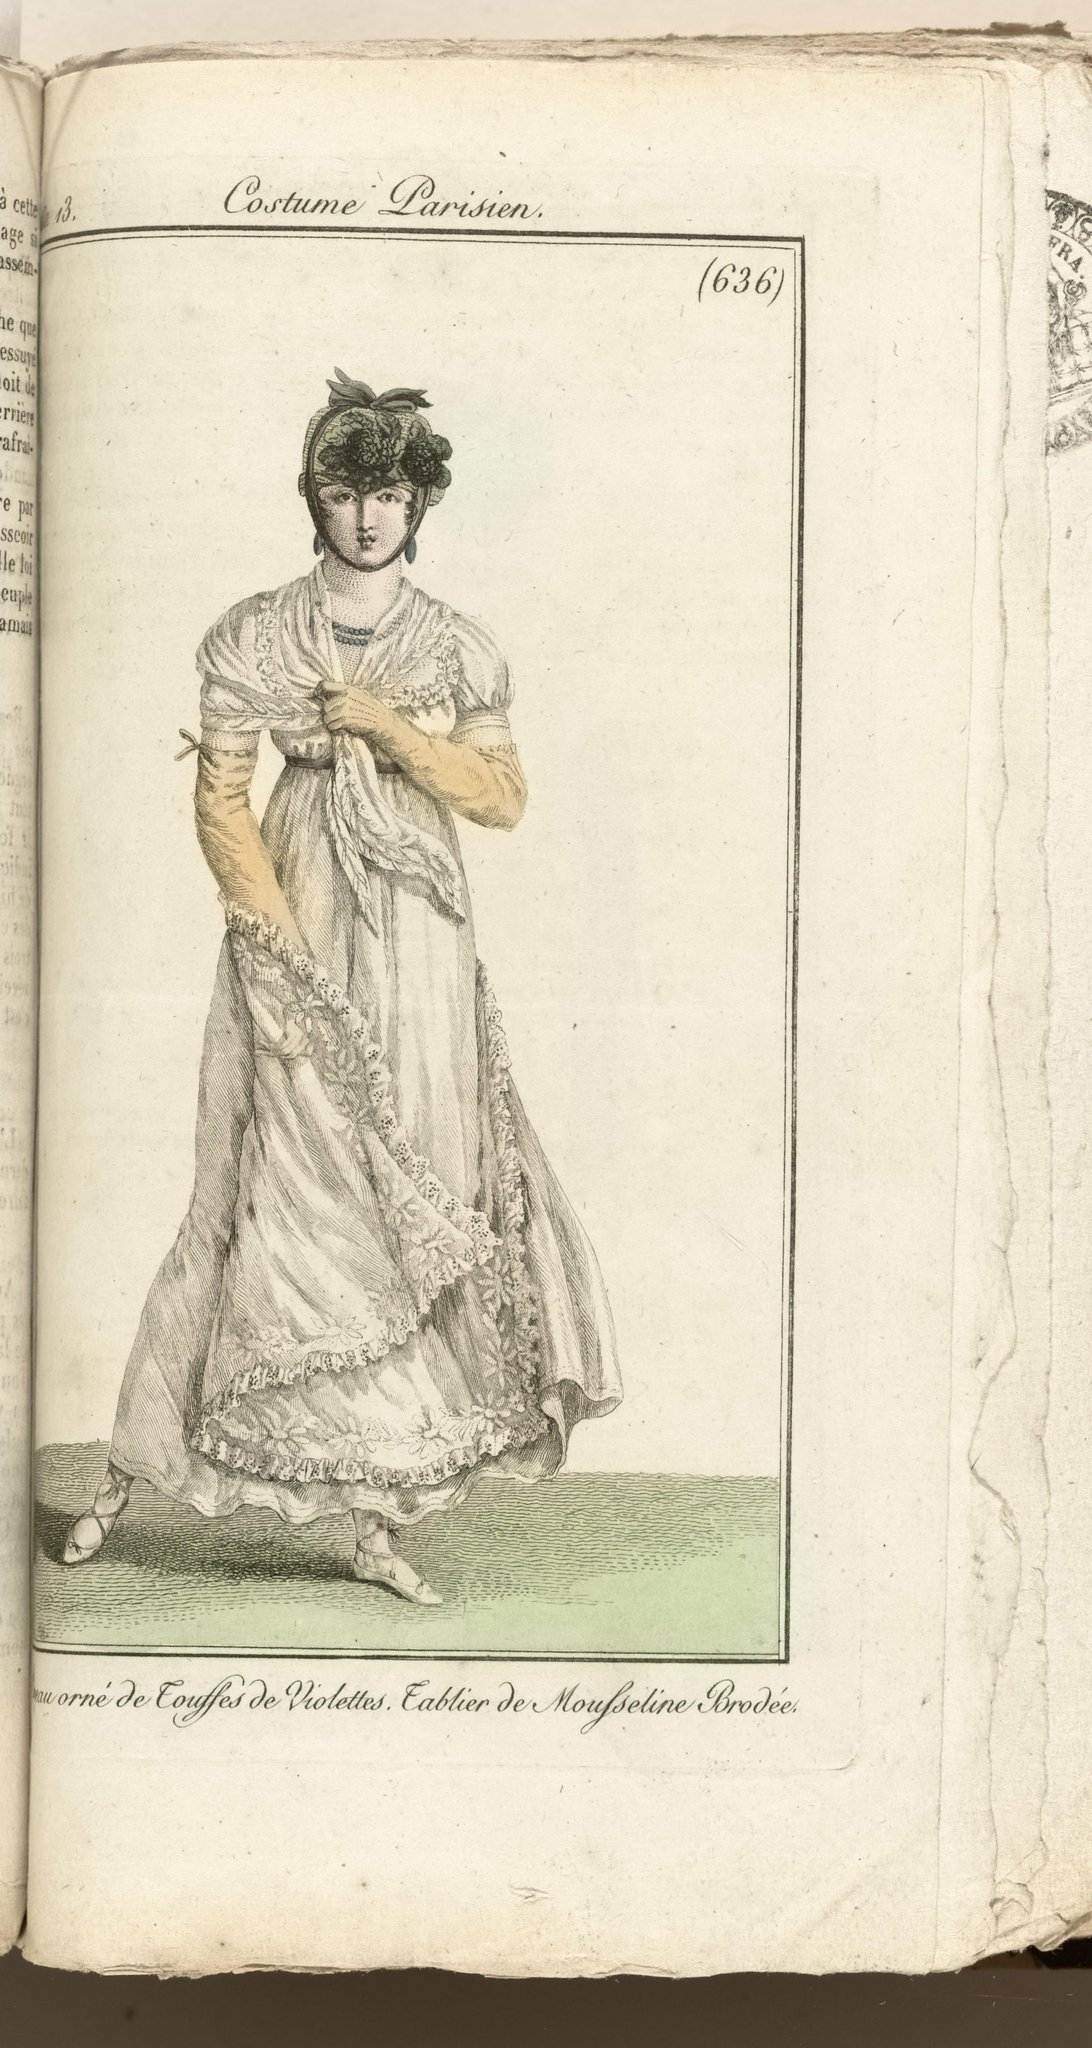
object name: fashion print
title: Journal des Dames et des Modes, Costume Parisien, 1805, An 13 (636) Chapeau orné de Touffes de Violettes.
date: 1805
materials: paper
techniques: engraving, hand coloring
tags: ear-rings (+ women's clothes), gloves, mittens (long gloves) (+ women's clothes), head-gear: cap (+ women's clothes), fashion plates, dress, gown (+ women's clothes), shoes, sandals, apron (+ women's clothes), pearl; pearl necklace (+ women's clothes)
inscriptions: title: ‘Chapeau orné de Touffes de Violettes. Tablier de Mousseline Brodée.’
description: Vrouw in witte japon met schort van witte mousseline, afgewerkt met rouches. Gele lange handschoenen. Mutsje met strik op het hoofd. Ketting en oorbellen. Witte platte schoentjes met kruisbandjes (cothurnes).